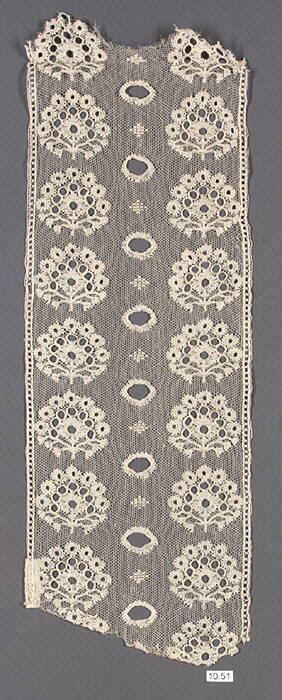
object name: piece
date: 1801-1900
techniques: lace